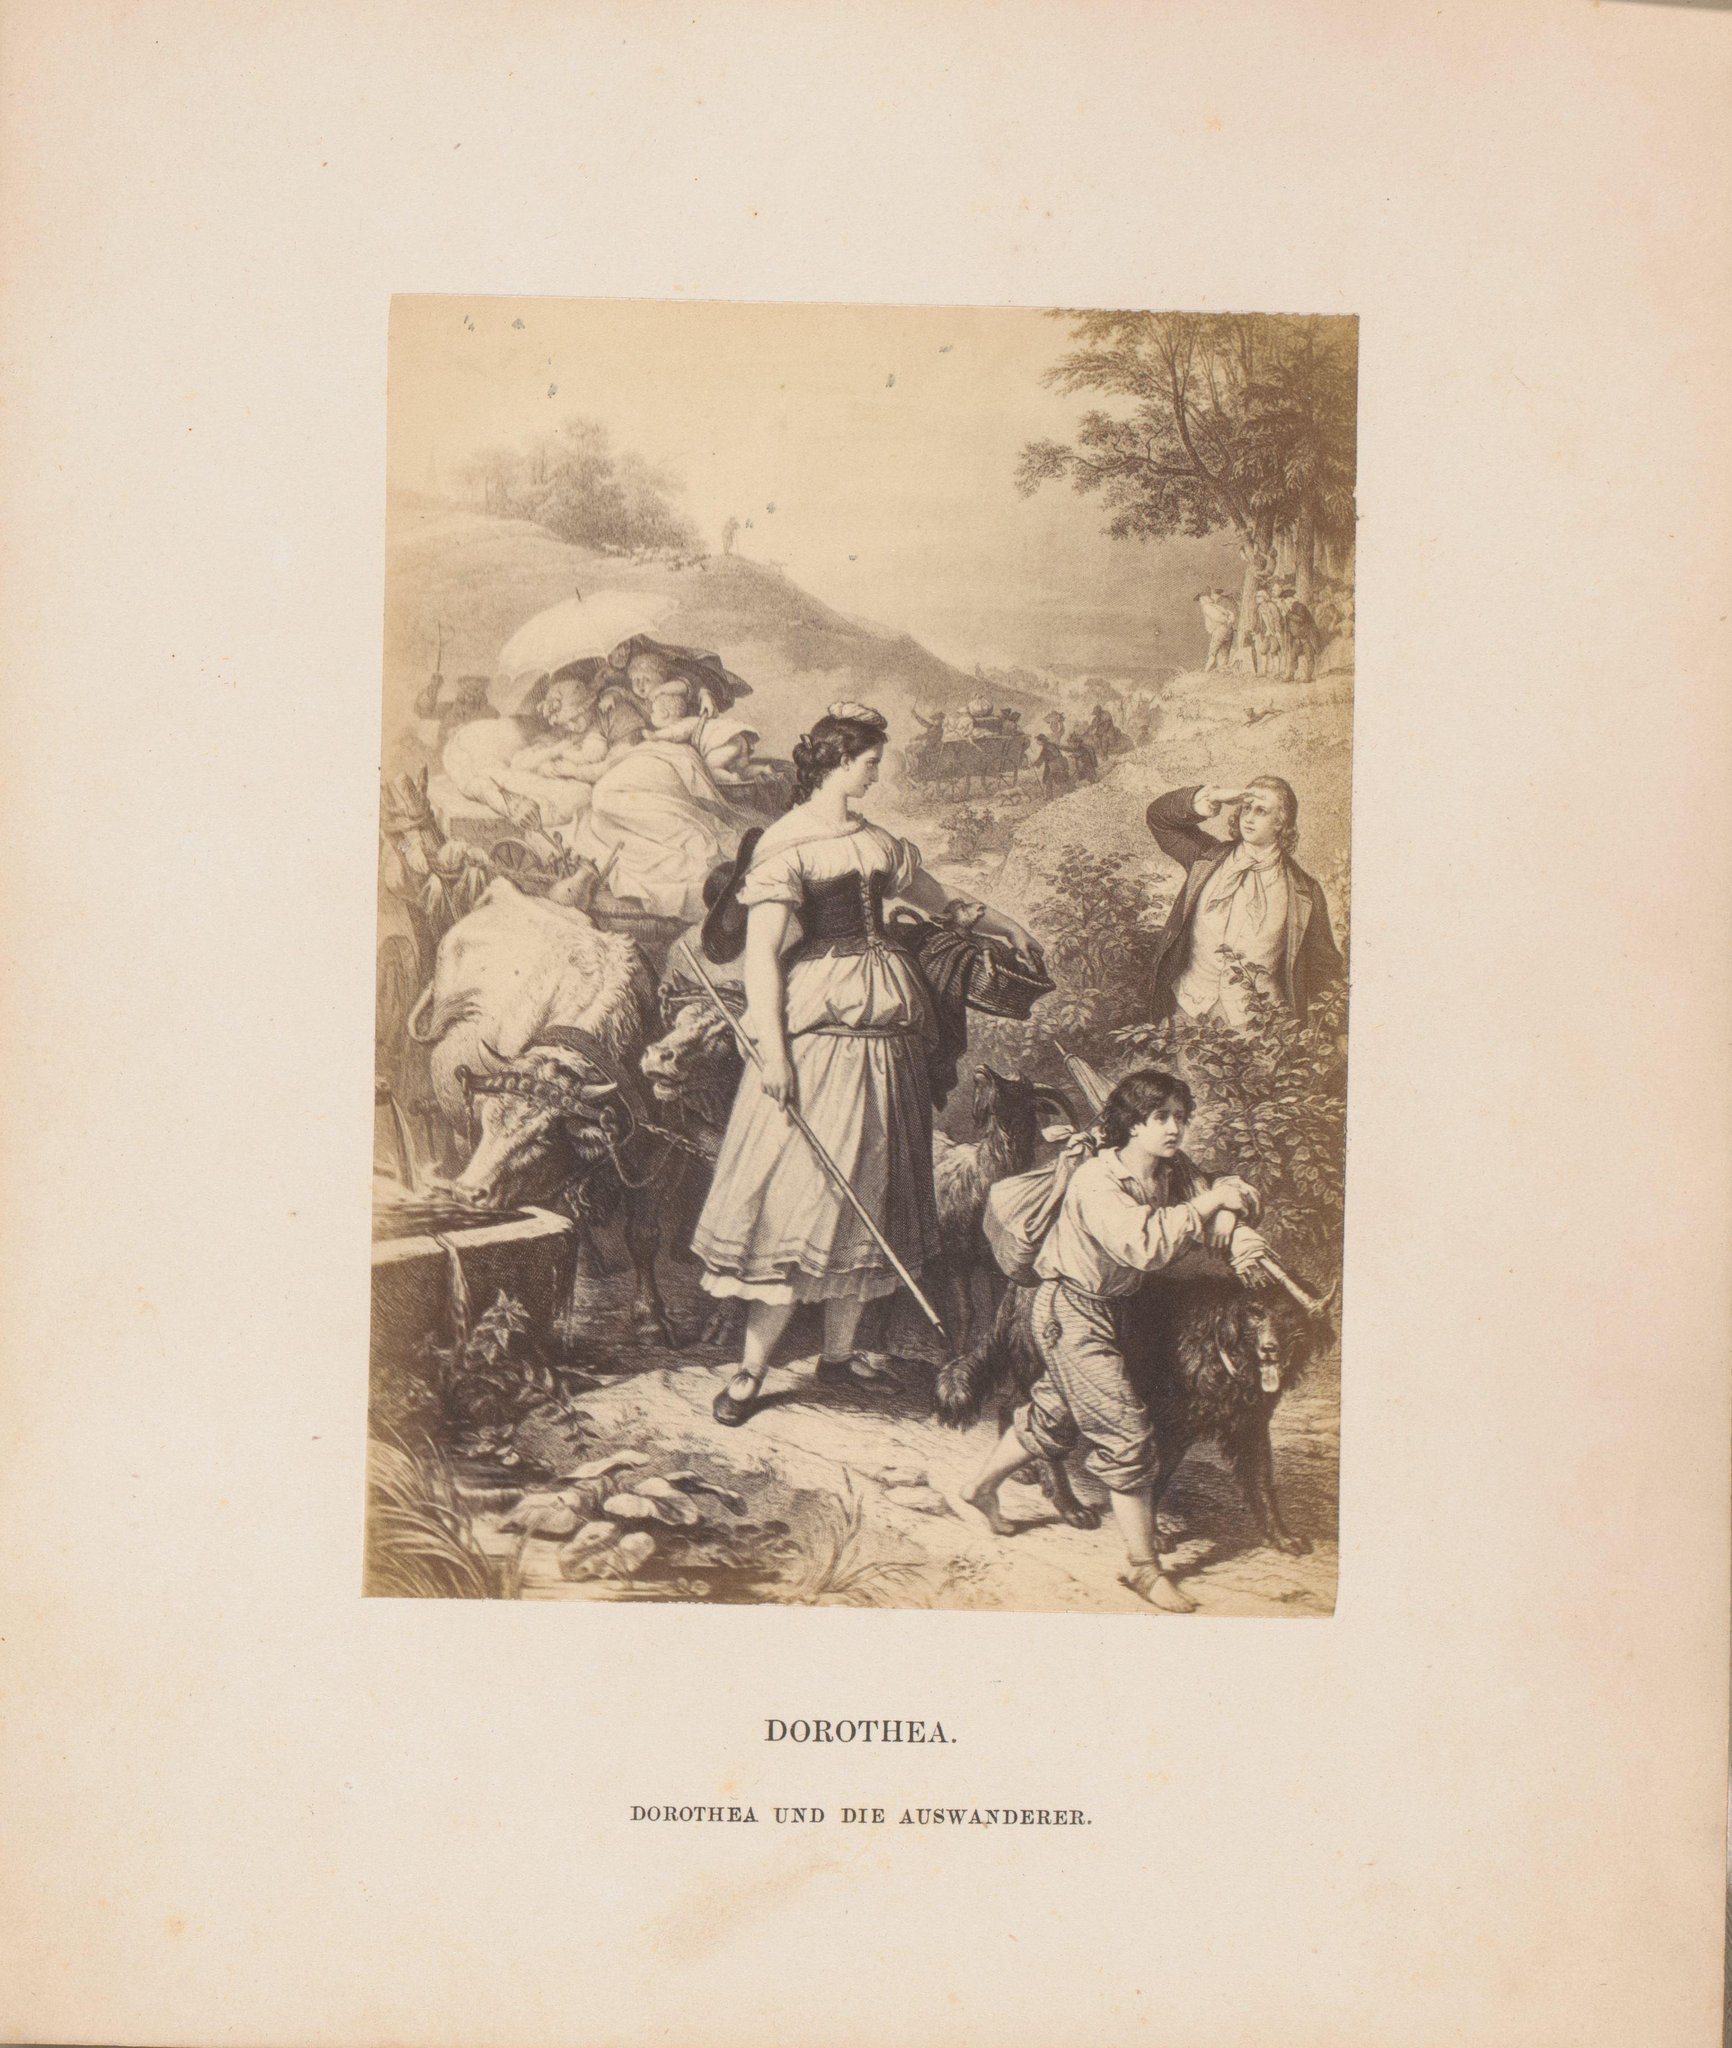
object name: reproduction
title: Fotoreproductie van een tekening van Dorothea met een groep reizigers uit Goethe's Hermann und Dorothea door Wilhelm von Kaulbach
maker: Anonymous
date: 1850-1900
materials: cardboard, photographic support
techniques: albumen print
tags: 'en route', traveller under way, specific works of literature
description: Deze foto maakt deel uit van een omslag met 22 foto's.